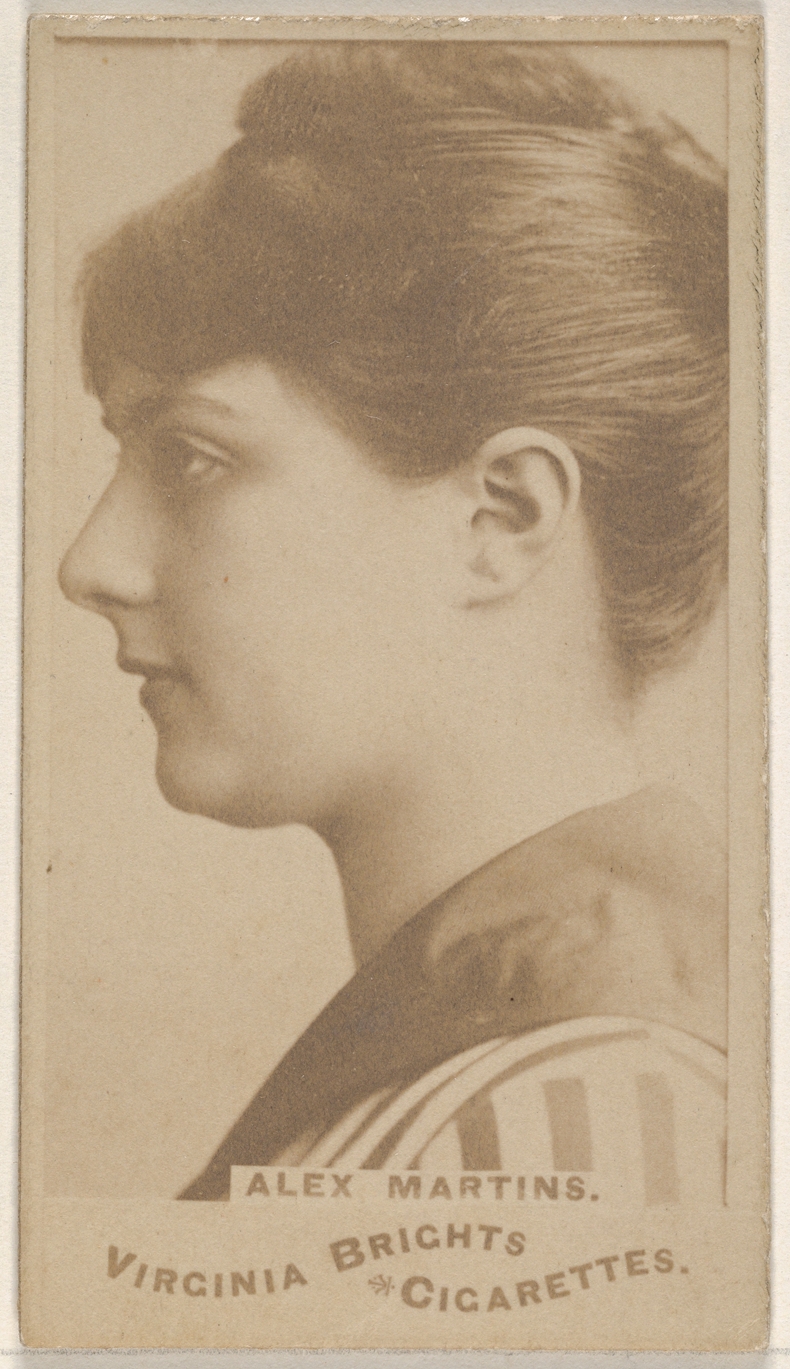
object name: photograph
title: Alex Martins, from the Actors and Actresses series (N45, Type 1) for Virginia Brights Cigarettes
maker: allen & ginter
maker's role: publisher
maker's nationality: american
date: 1888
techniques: albumen silver print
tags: portraits,profiles,women,actresses